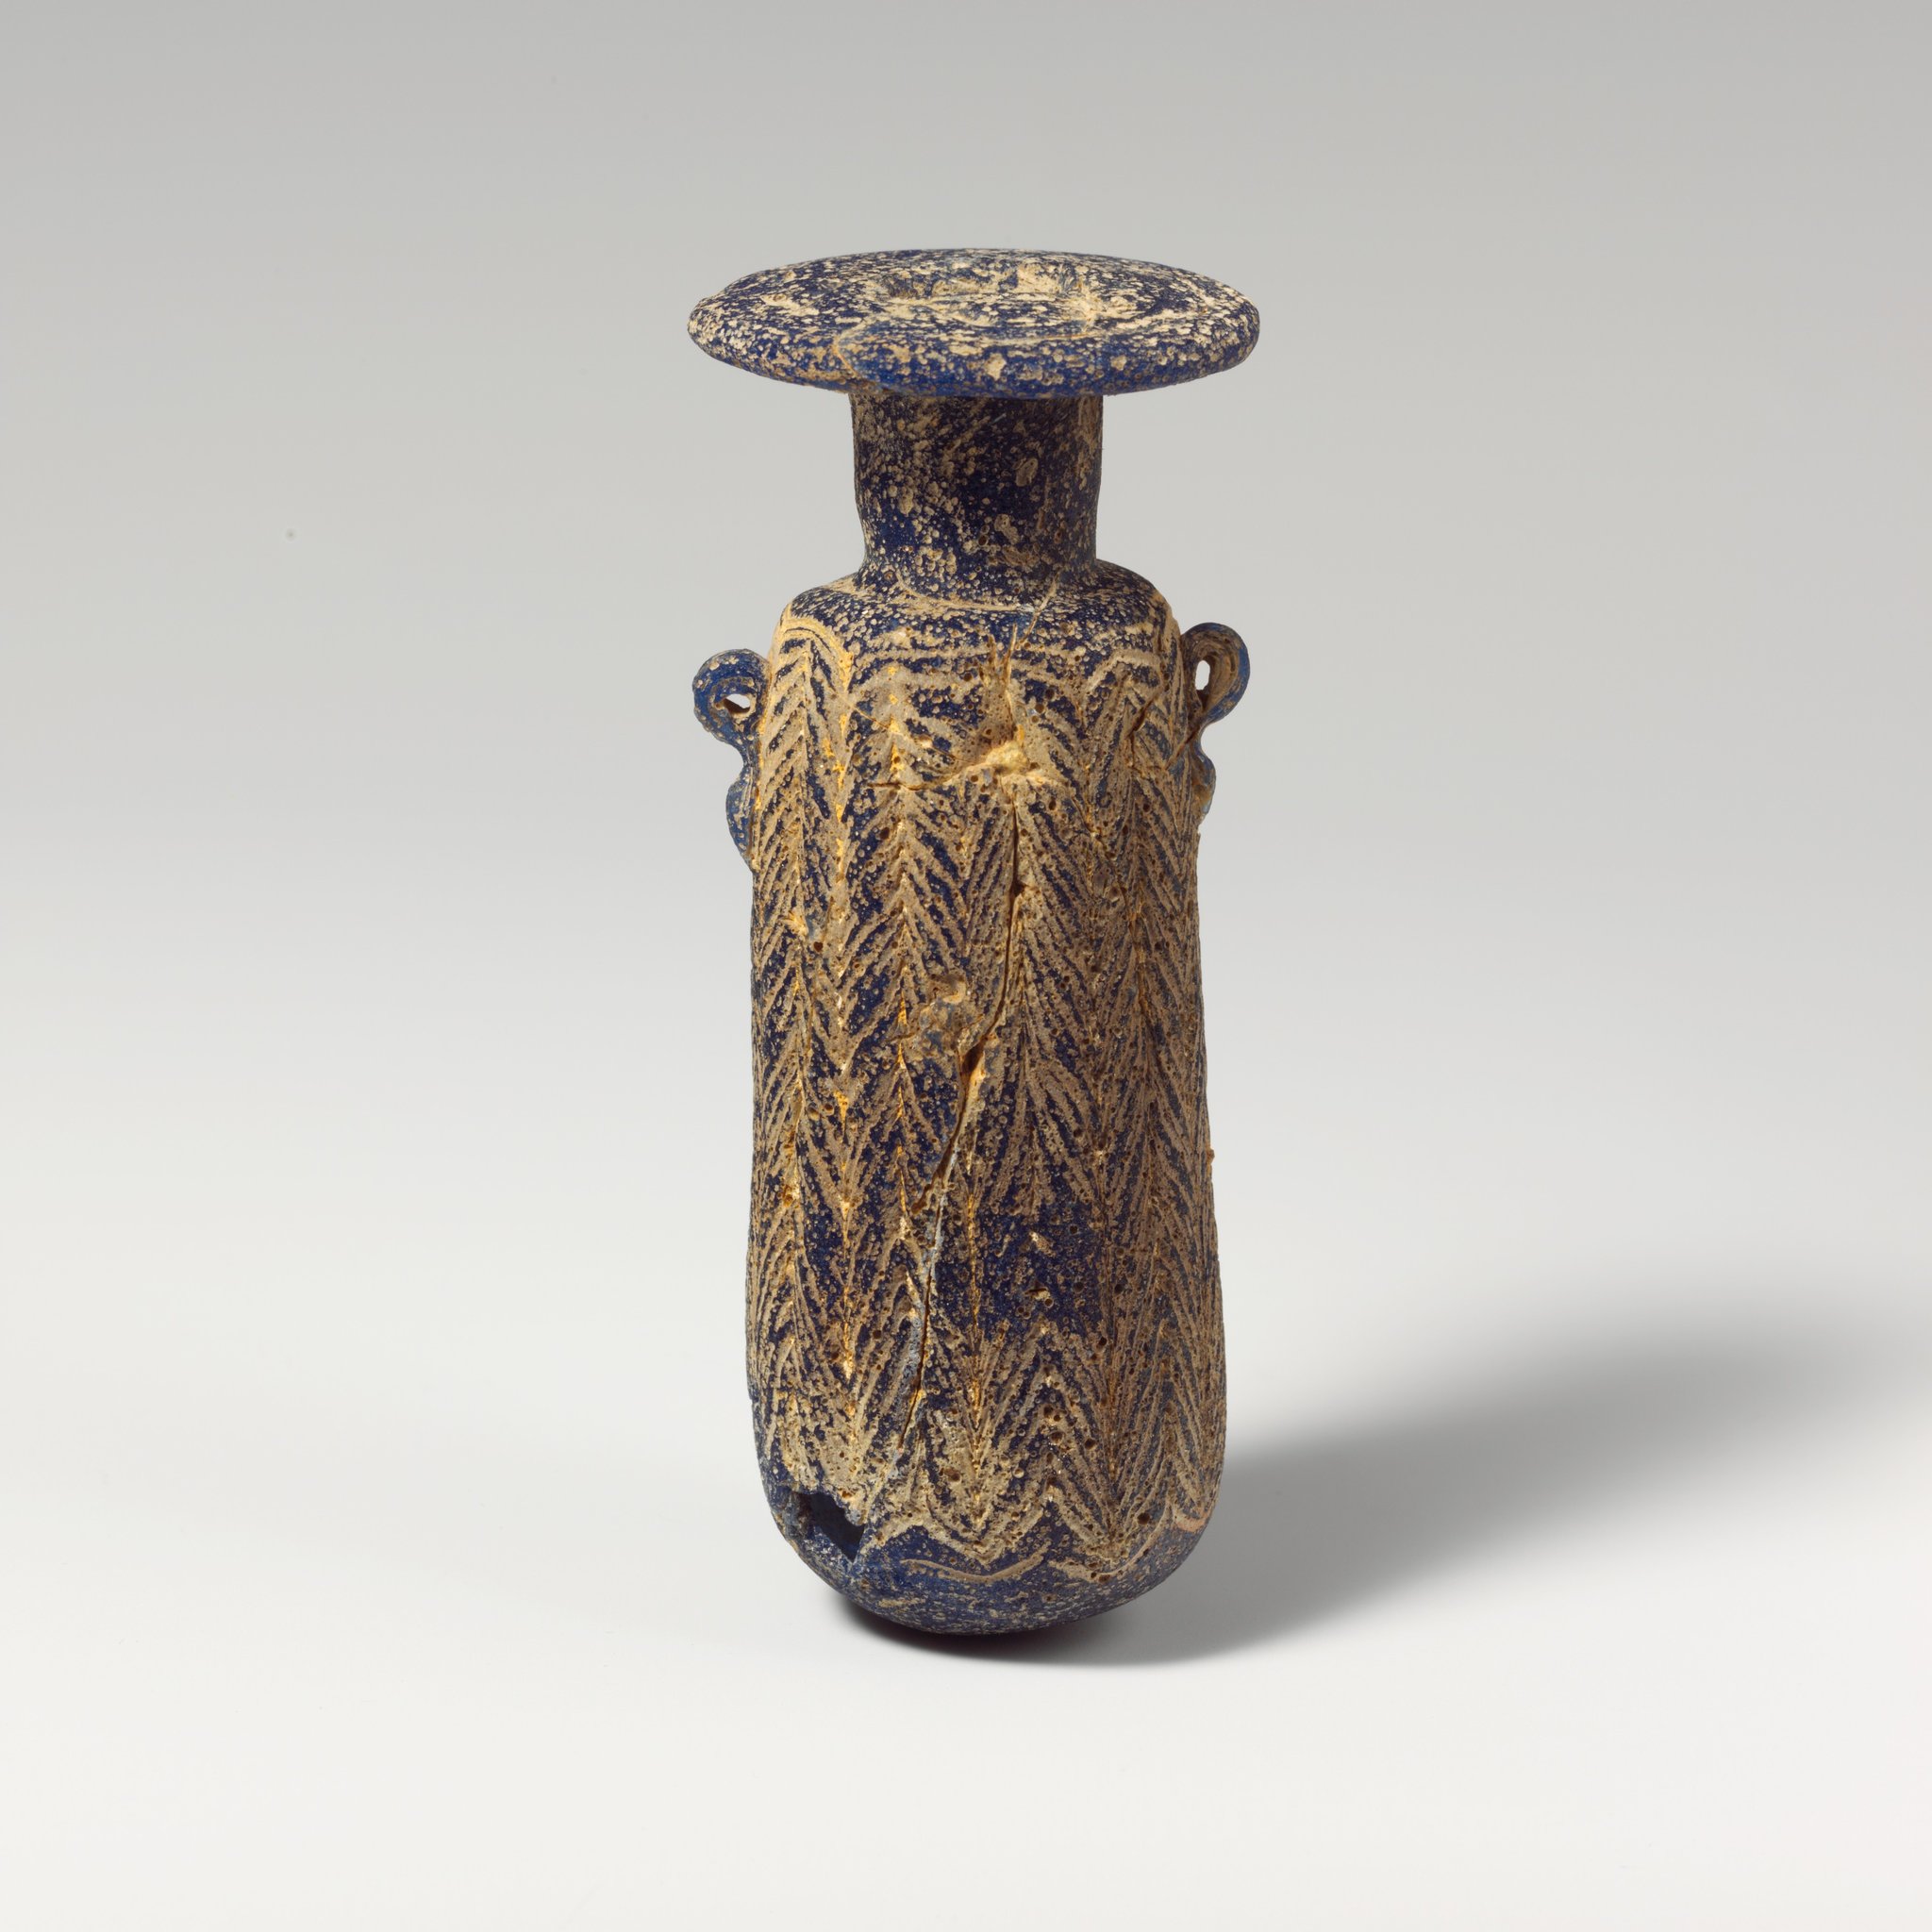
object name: alabastron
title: Glass alabastron (perfume bottle)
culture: greek or eastern mediterranean or italian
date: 367-268 BCE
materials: glass